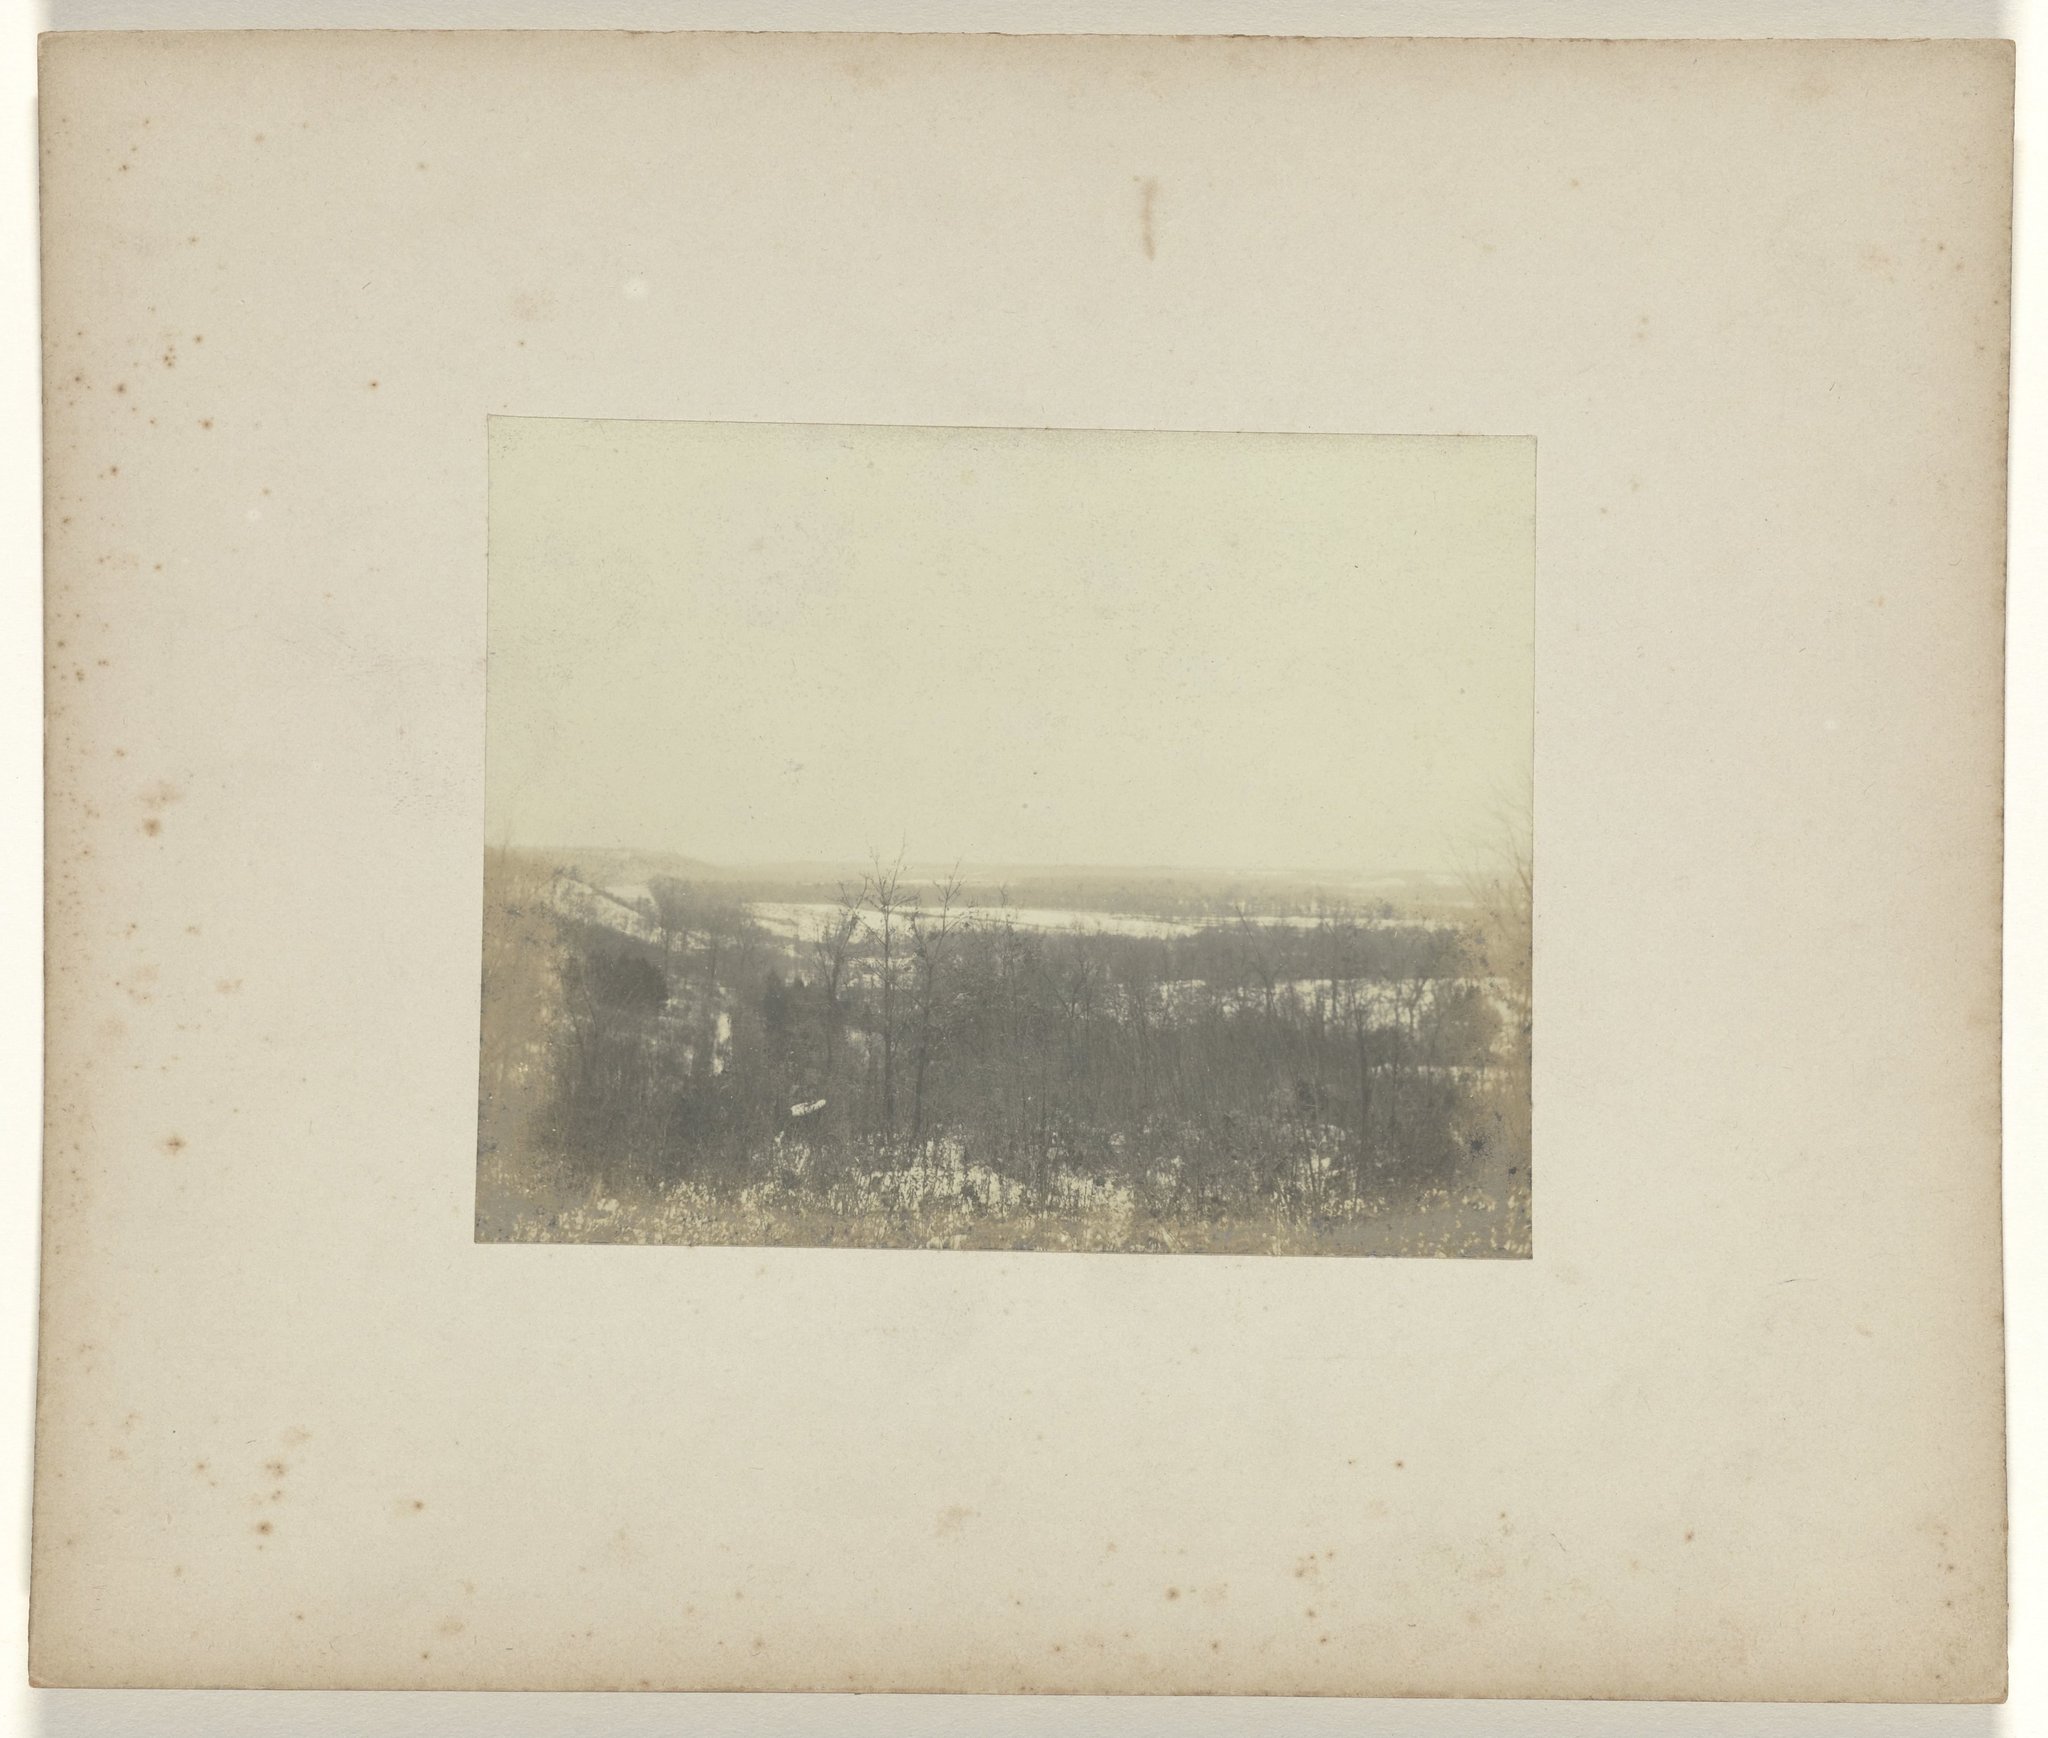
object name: photograph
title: Panoramisch gezicht vanaf Meramec Highlands tijdens de wereldtentoonstelling in St. Louis (Louisiana Purchase Exposition), 1904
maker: jan schüller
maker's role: draughtsman, painter, print maker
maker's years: 1871-1915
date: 1904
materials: cardboard, paper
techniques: gelatin silver print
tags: missouri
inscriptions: annotation: ‘Heerlijk panorama van af // de Meramec Highlands op Mustanzi [?] staat’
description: Panoramisch gezicht vanaf Meramec Highlands tijdens de wereldtentoonstelling in St. Louis (Louisiana Purchase Exposition), 1904.